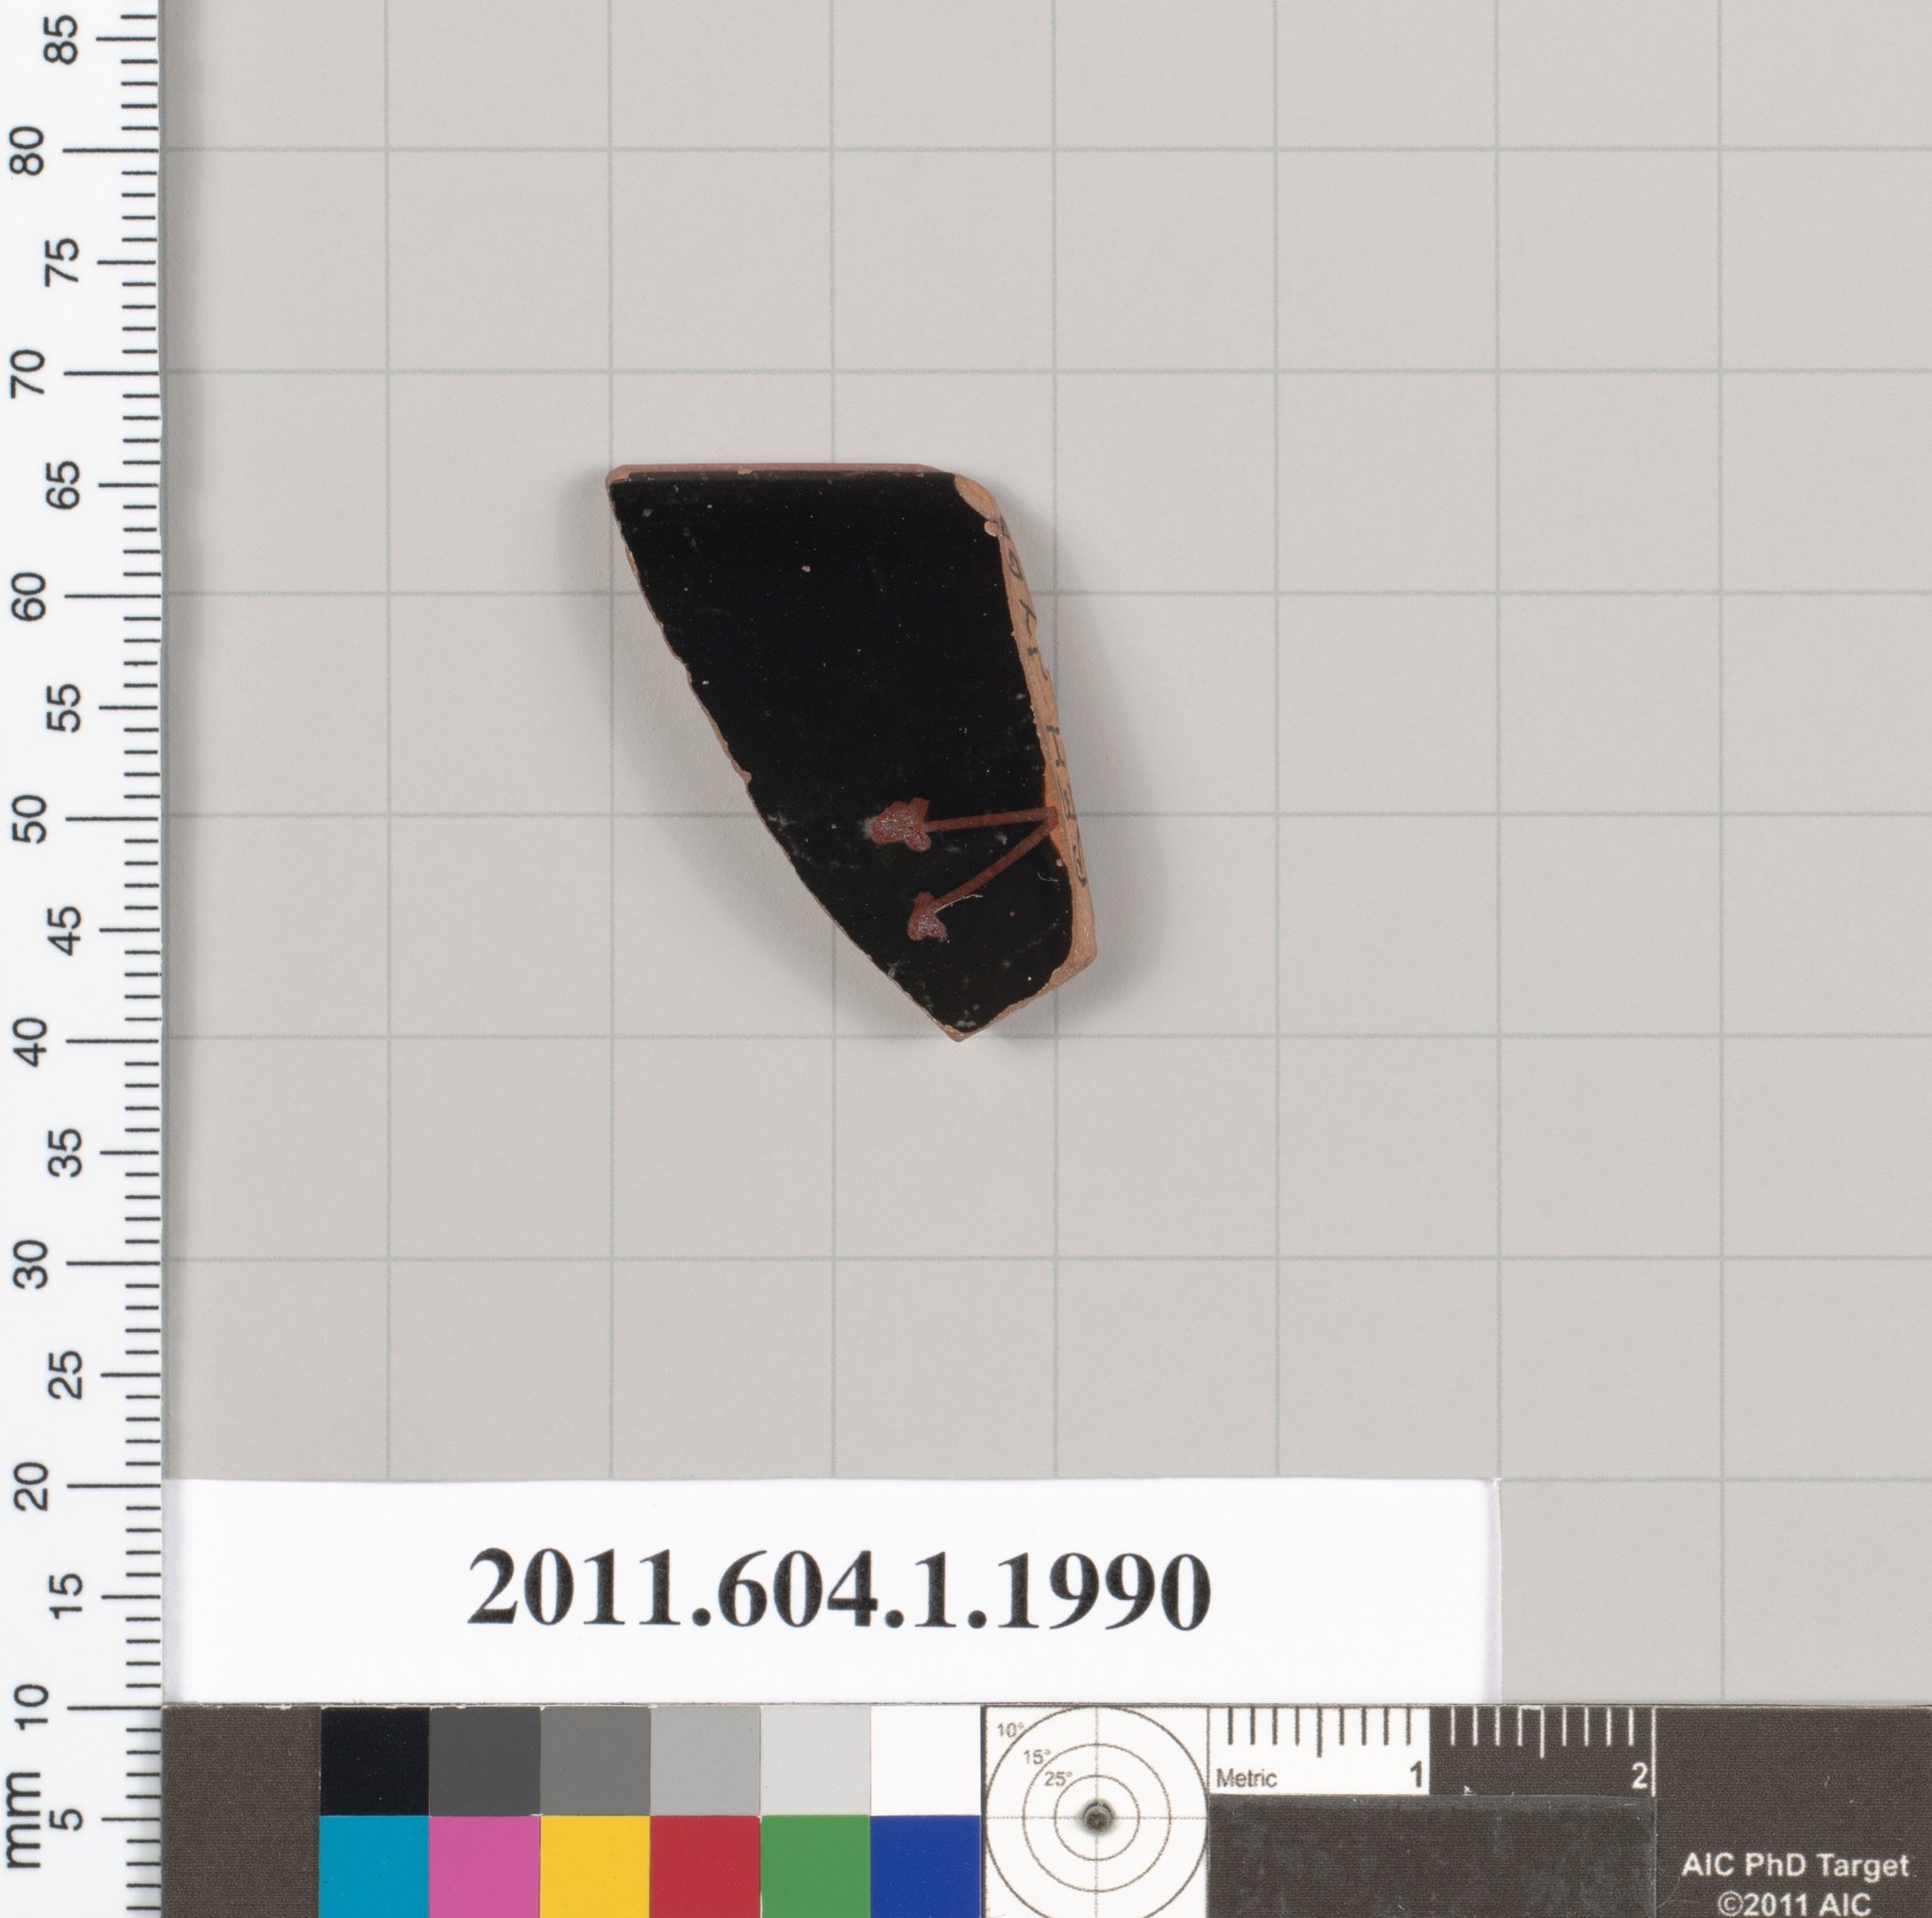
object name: kylix fragment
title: Terracotta rim fragment of a kylix (drinking cup)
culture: greek, attic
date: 490-480 BCE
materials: terracotta